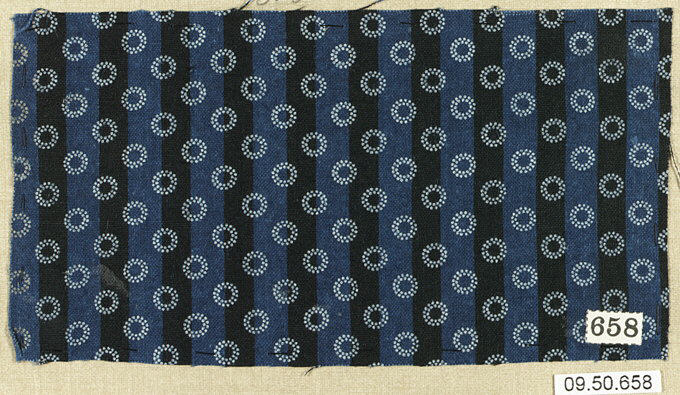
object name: piece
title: Pieces (6)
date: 1801-1900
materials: cotton